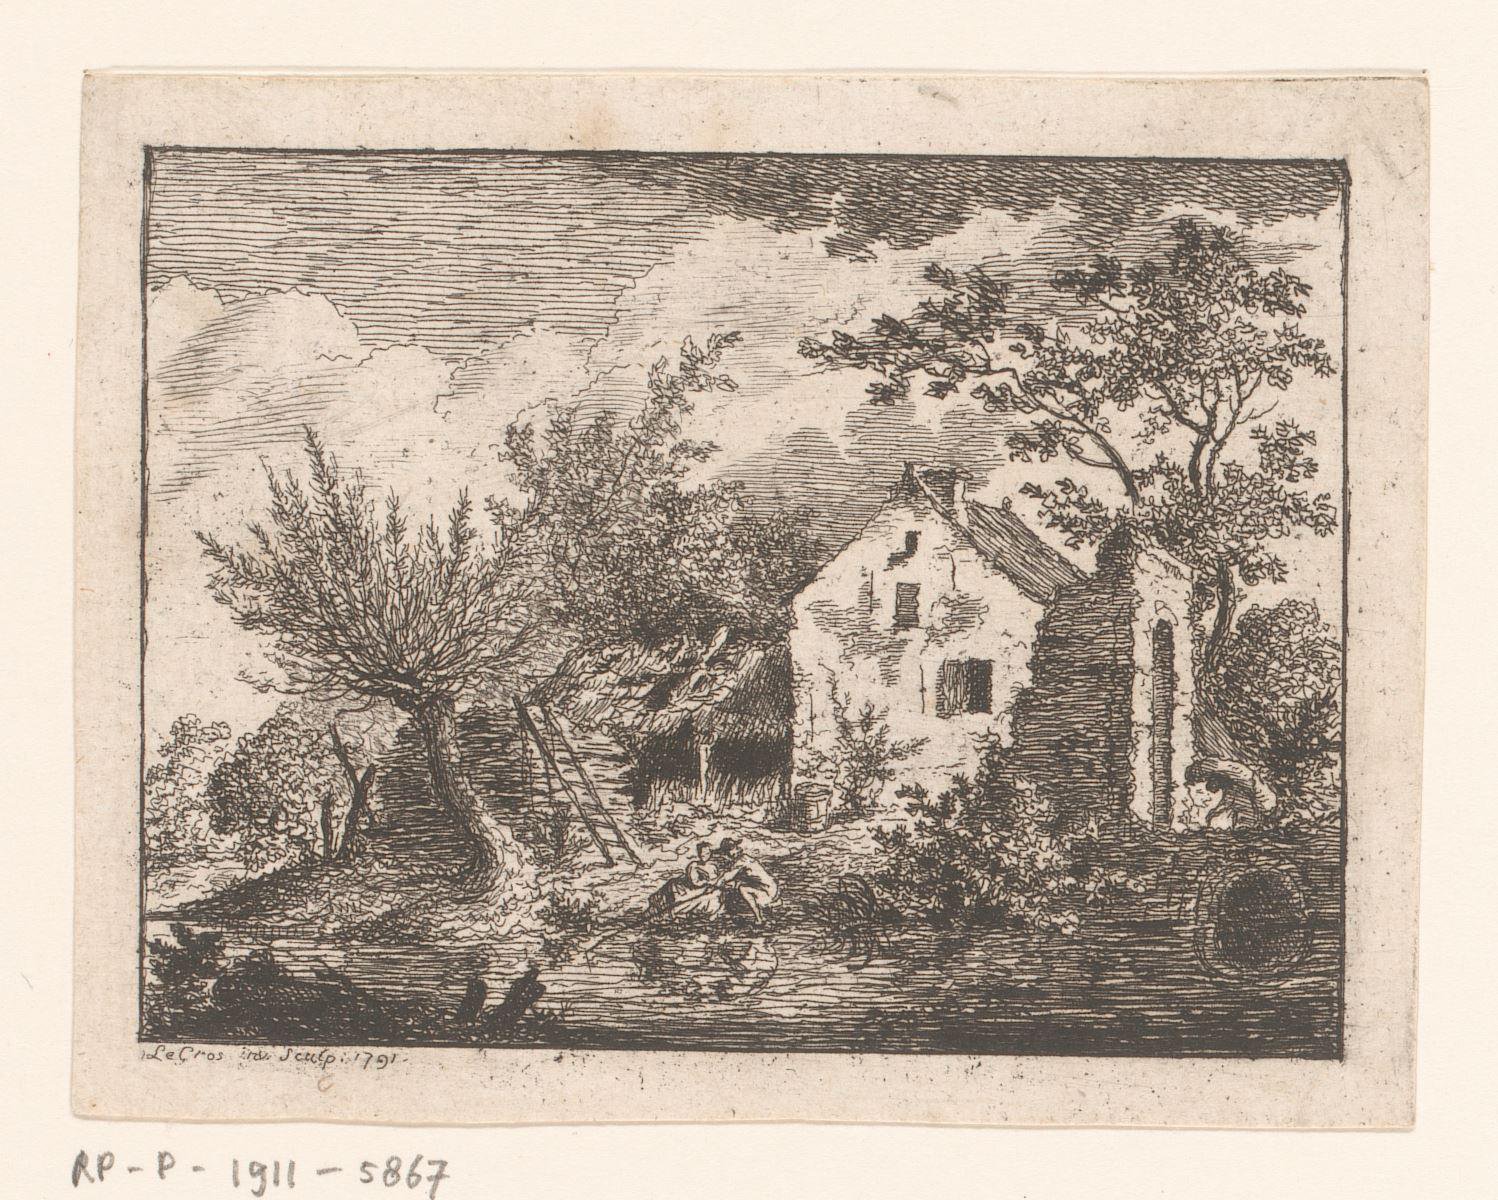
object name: print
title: Landschap met een man en een vrouw voor een huis aan het water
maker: sauveur legros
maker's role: print maker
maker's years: 1754-1834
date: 1791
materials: paper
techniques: etching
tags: cottage, ladder, farm or solitary house in landscape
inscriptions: collector's mark: Lugt 2228